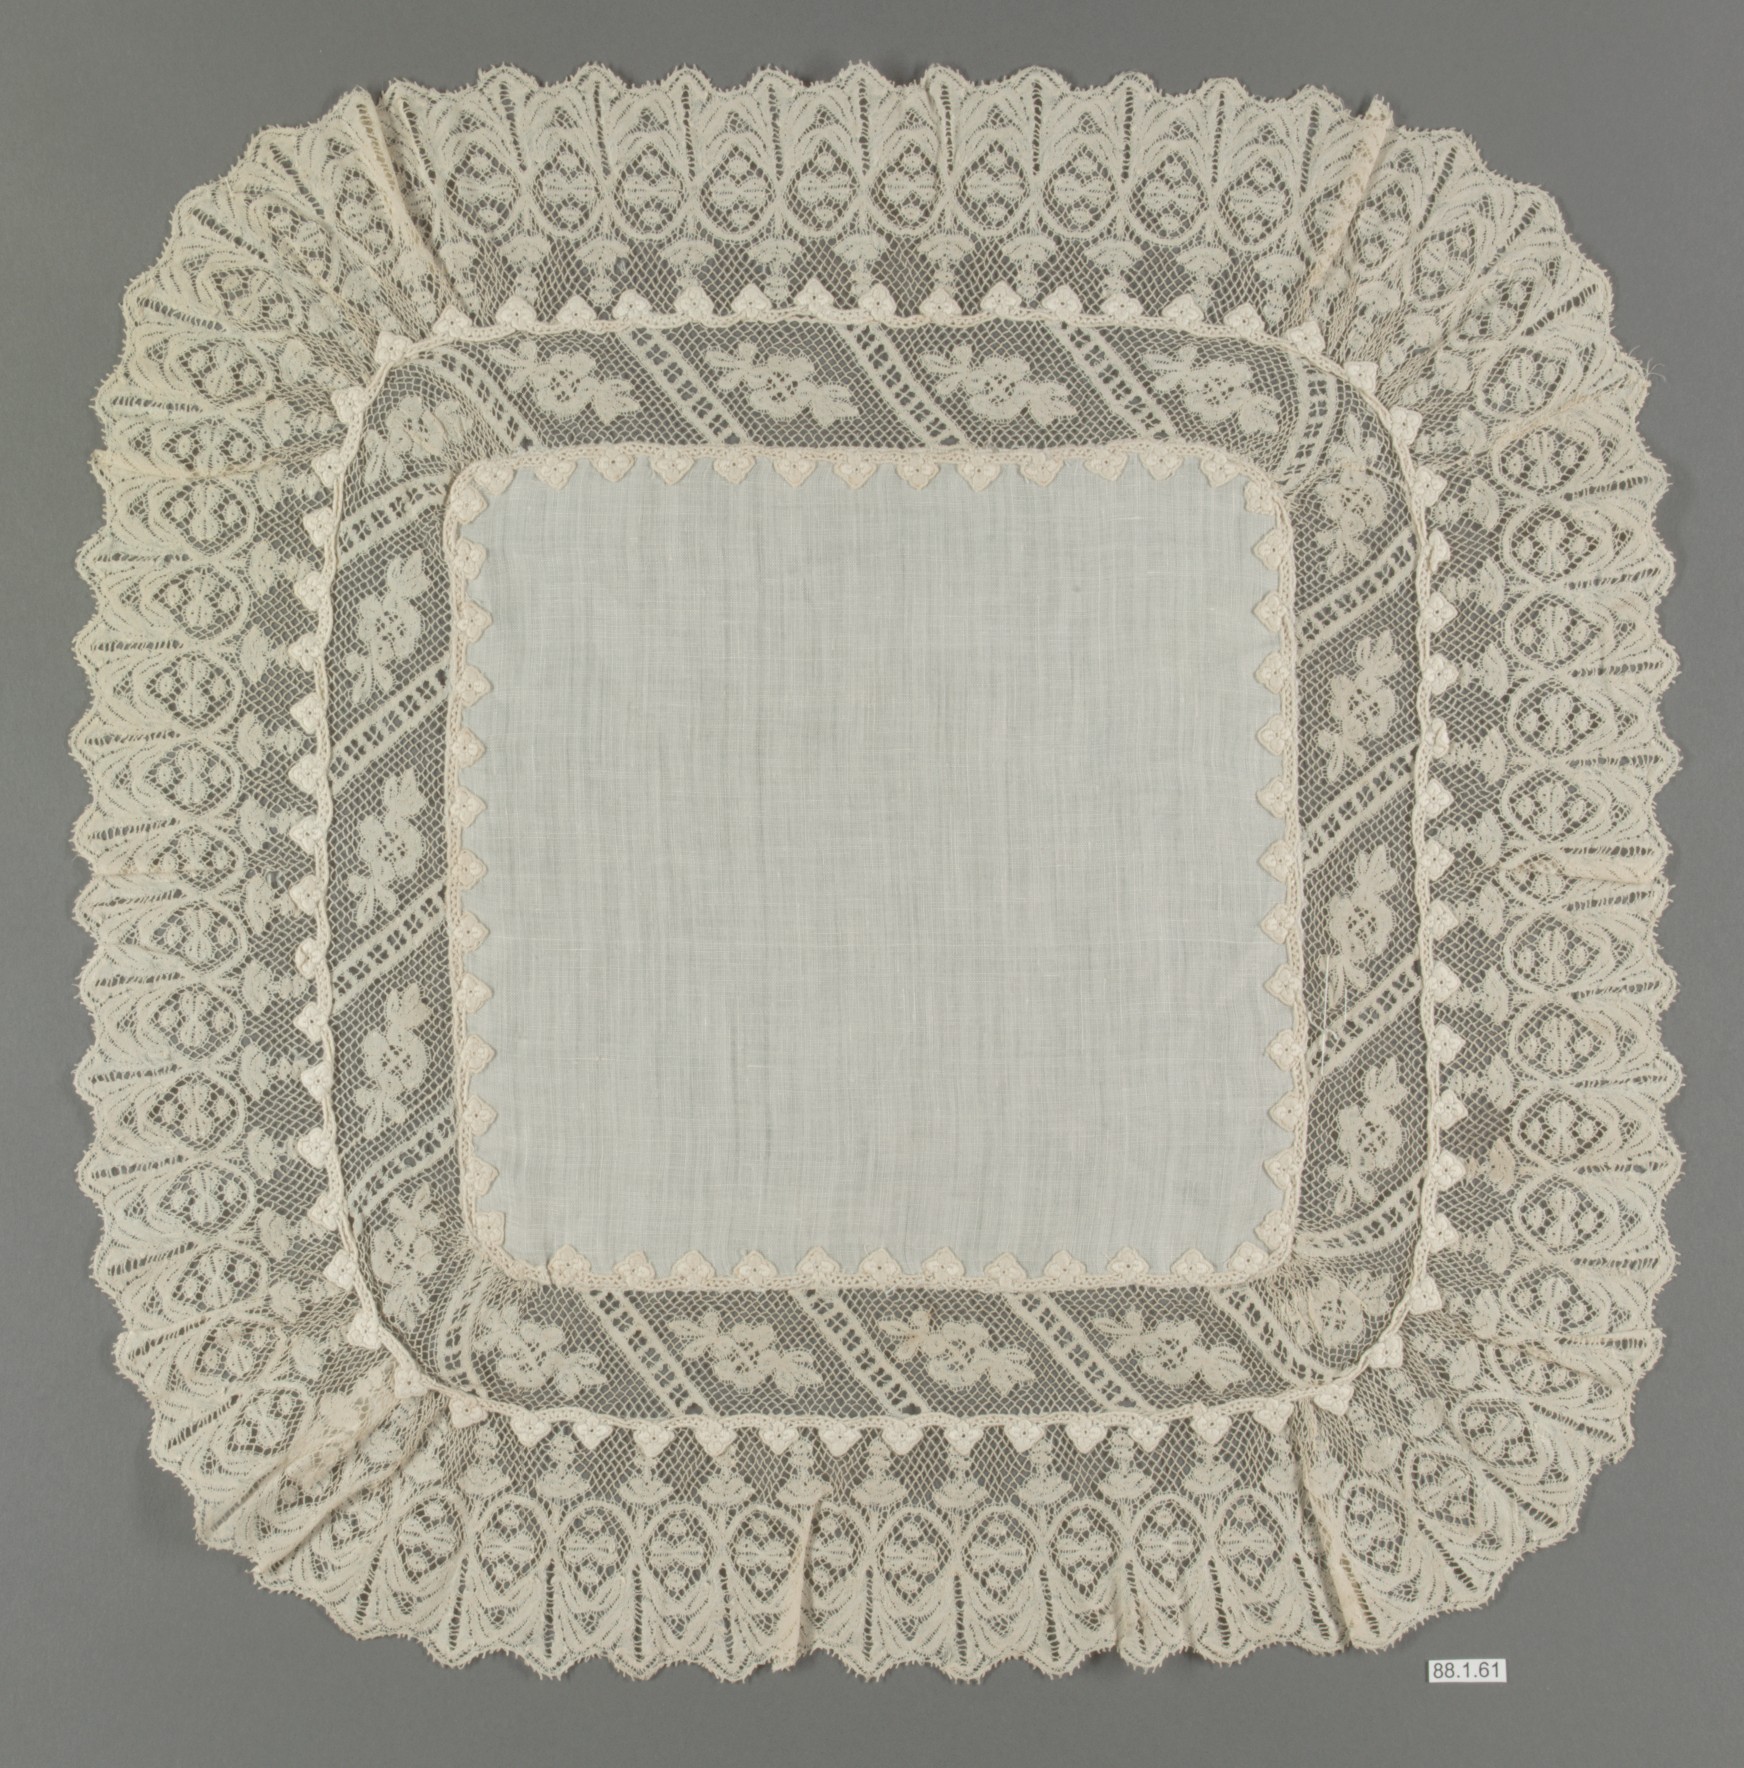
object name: handkerchief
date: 1801-1900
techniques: lace